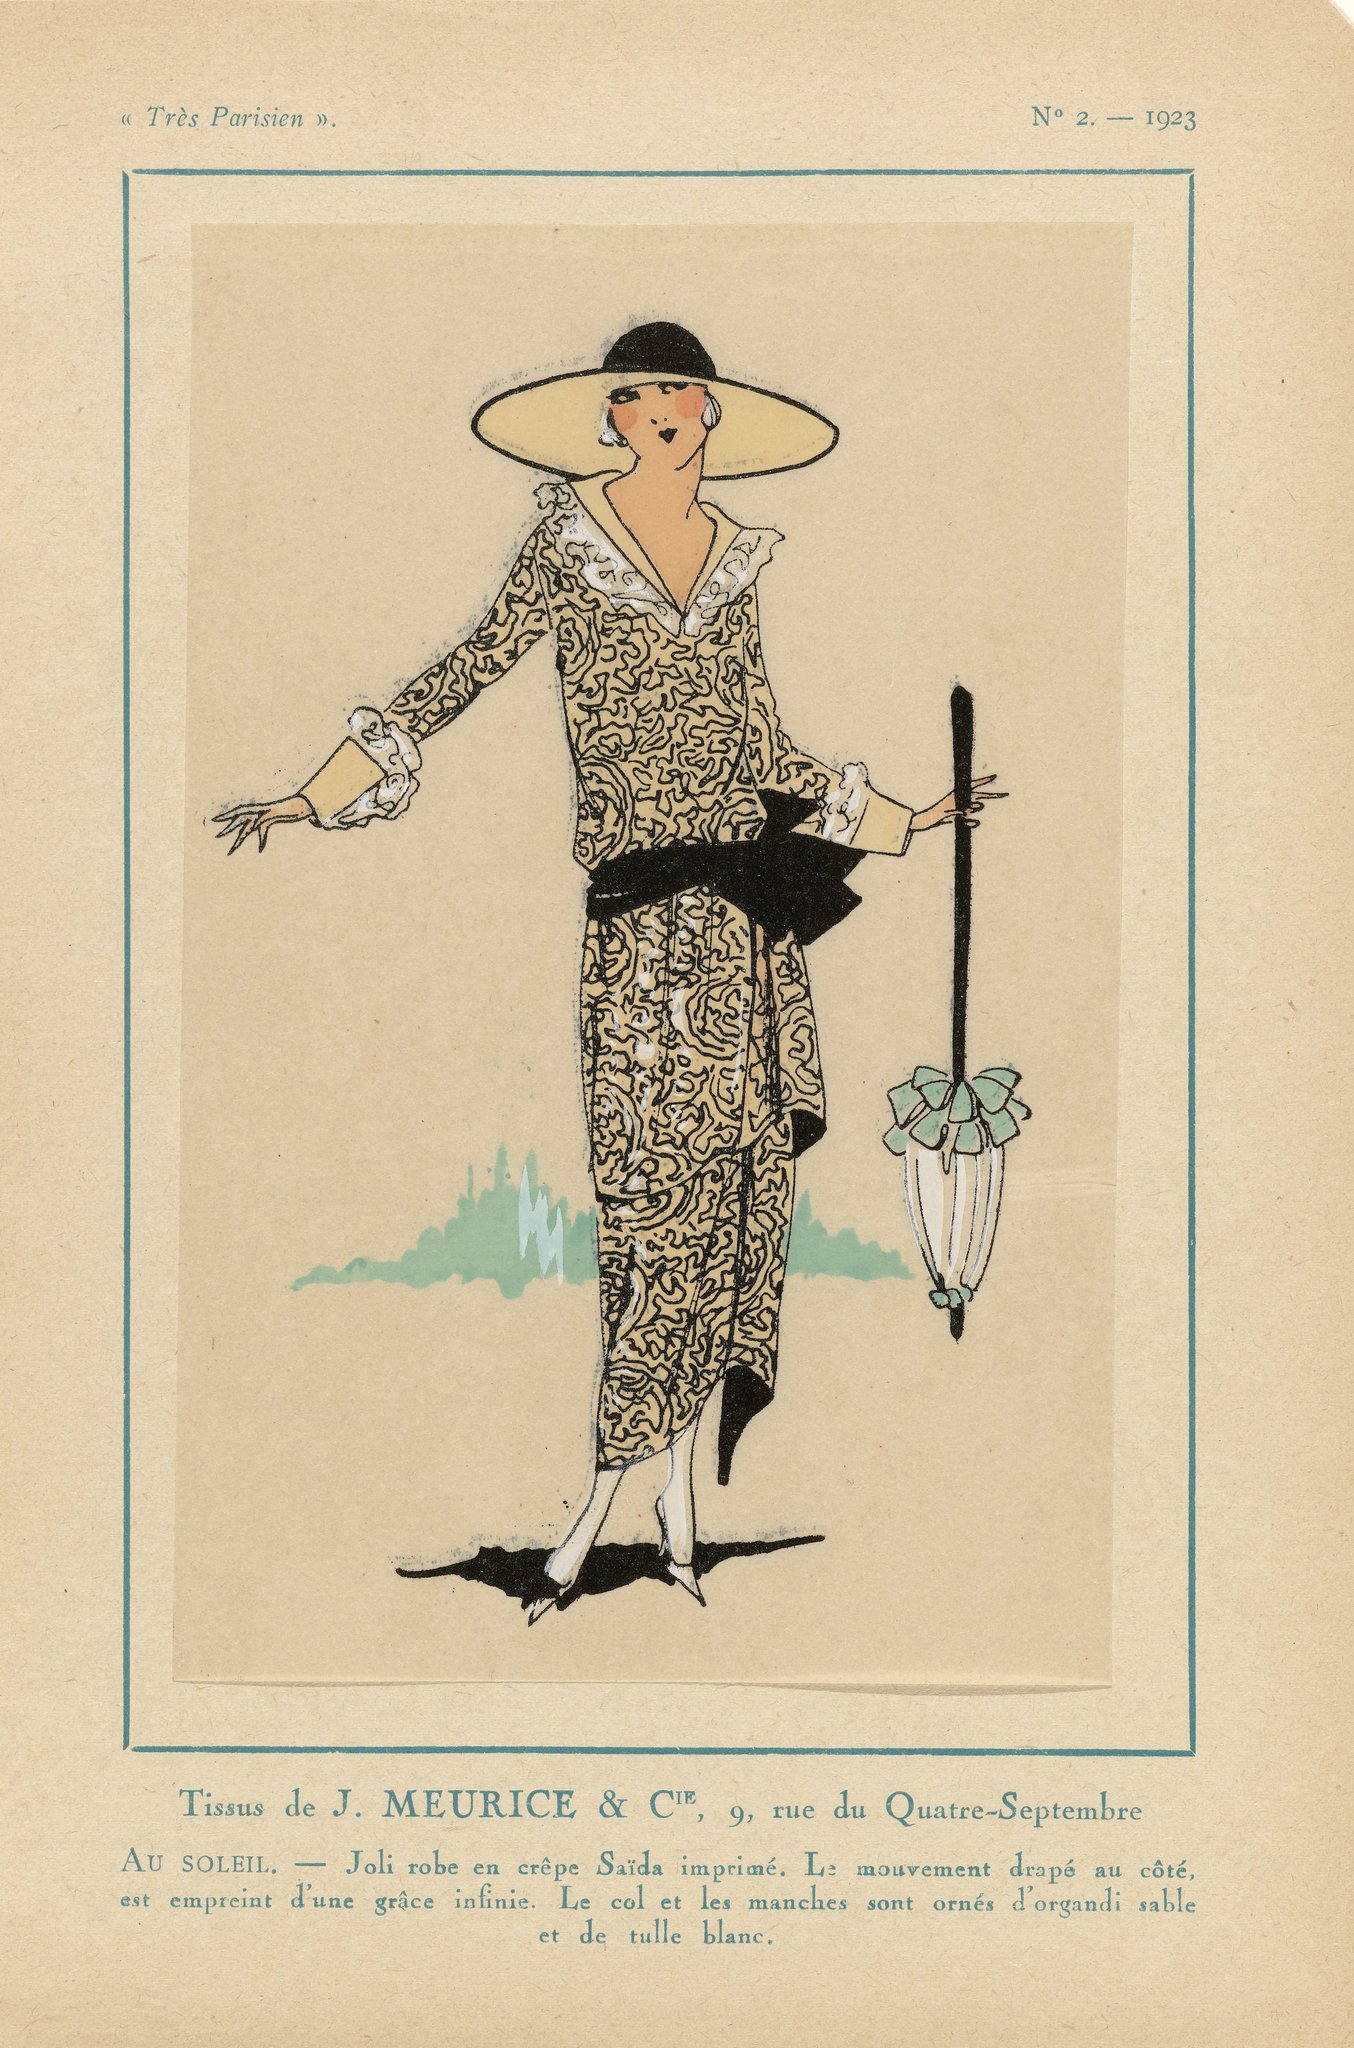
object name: fashion print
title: Très Parisien, 1923, No. 2: Tissus de J. MEURICE & CIE...Au soliel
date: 1923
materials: paper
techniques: hand coloring, letterpress printing, lithography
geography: paris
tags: walking-stick, staff, cane (+ women's clothes), neck-gear: collar (+ women's clothes), fashion plates, head-gear: hat (+ women's clothes), sleeves: cuffs (+ women's clothes), dress, gown (+ women's clothes)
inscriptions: title: ‘Très Parisien / No 2. - 1923’, caption: ‘Tissus de J. MEURICE & CIE, 9, rue du Quatre-Septembre / AU SOLEIL. - Joli robe en crêpe Saïda imprimé. Le mouvement drapé au côté, est empreint d'une grâce infinie. Le col et les manches sont ornés d'organdi sable et de tulle blanc.’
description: Stoffen van J. Meurice & Cie. Jurk van bedrukte 'crêpe Saïda'. De kraag en manchetten zijn versierd met 'organdi sable' en witte tule. Accessoires: hoed met brede rand, parasol. Prent uit het modetijdschrift Très Parisien (1920-1936).